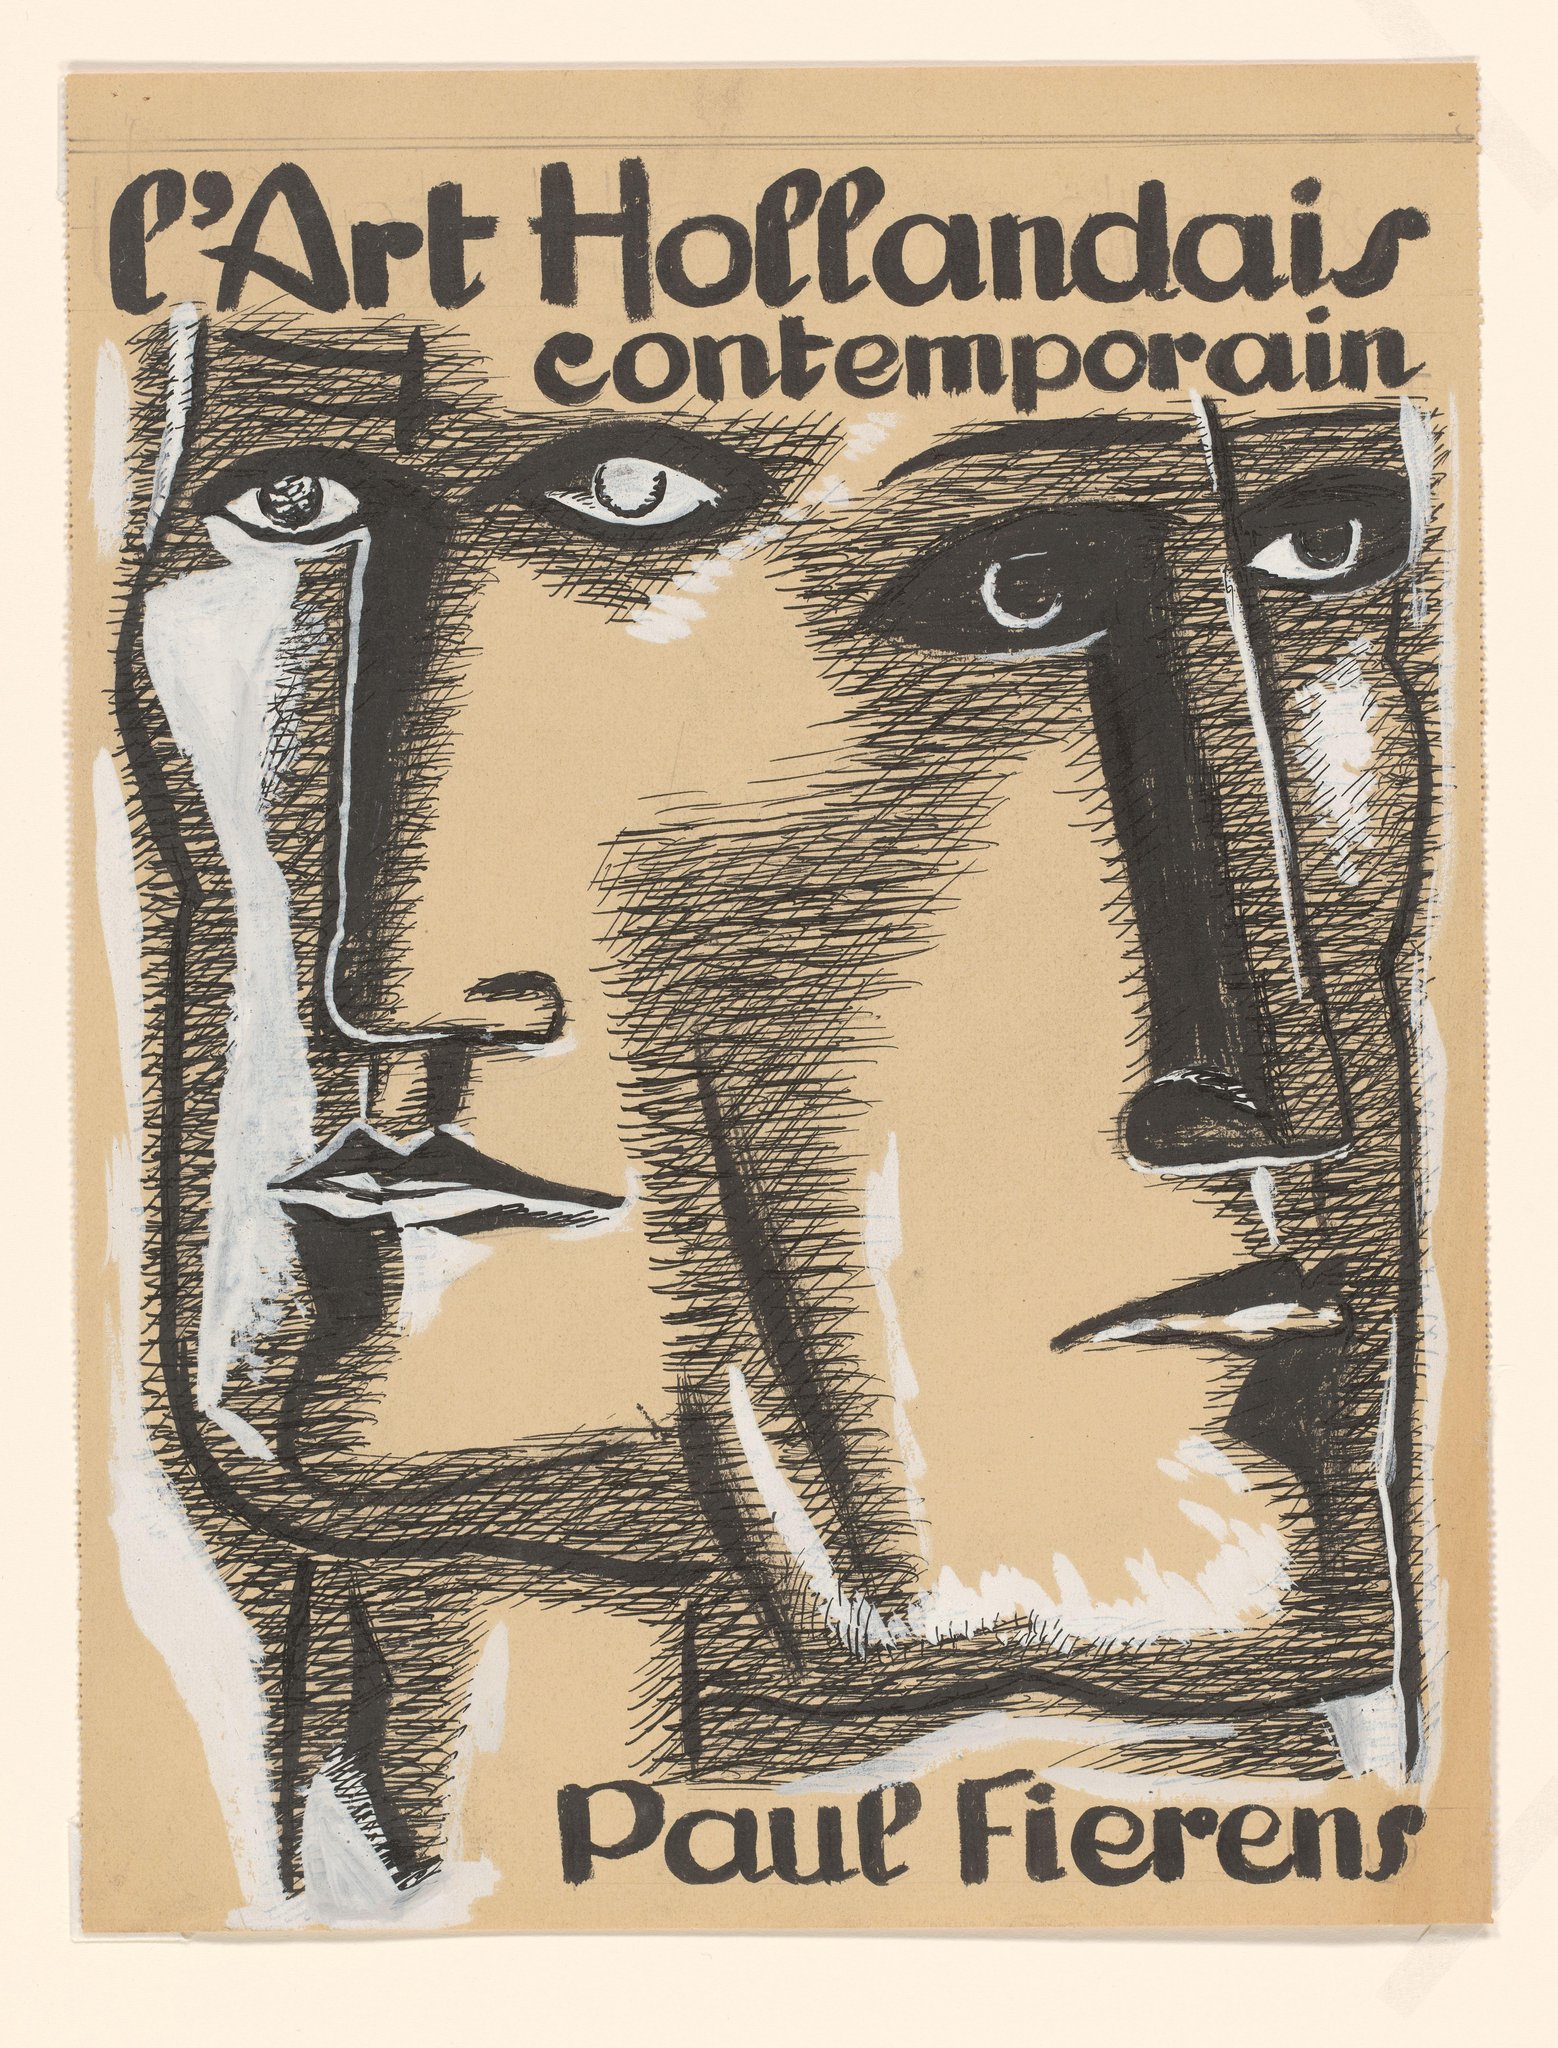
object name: drawing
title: Ontwerp boekomslag "l'Art Hollandais contemporain"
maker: leo gestel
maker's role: draughtsman, print maker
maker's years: 1881-1941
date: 1933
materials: paint, ink, paper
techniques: brush, pen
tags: paris, brussels, head turned sideways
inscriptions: inscription: ‘L'Art Hollandais / contemporain’, inscription: ‘Paul Fierens’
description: Ontwerp boekomslag, met twee gestileerde mannen gezichten, voor Paul Fierens, "l'Art Hollandais contemporain" (Parijs 1933).